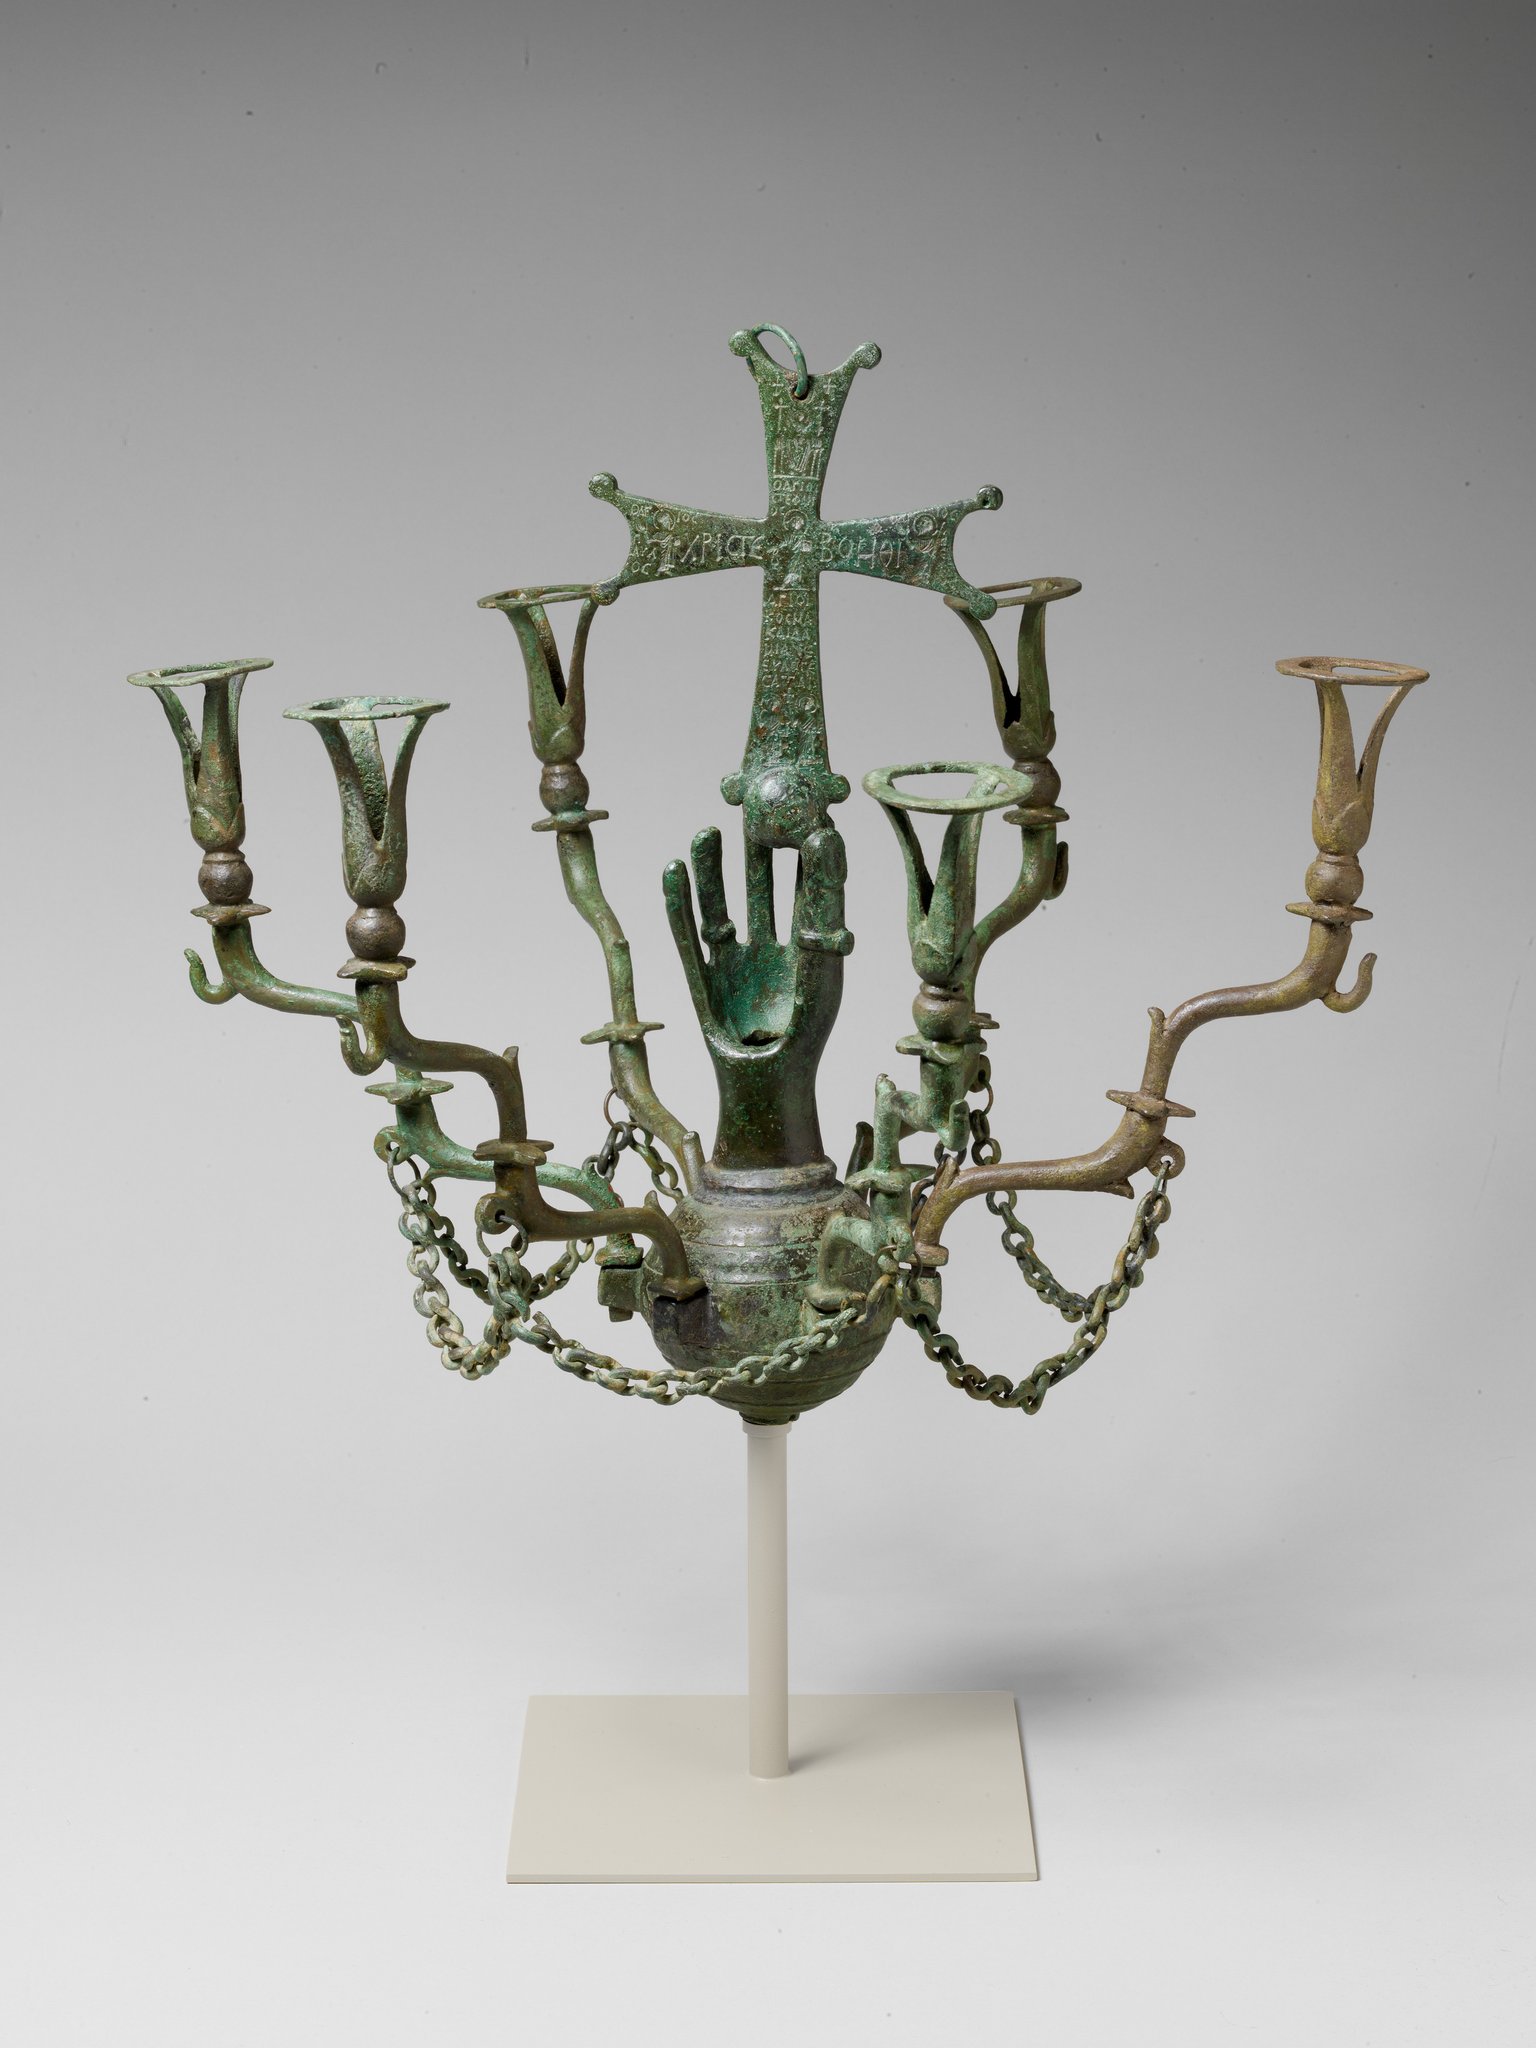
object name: chandelier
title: Hanging Lamp with a Hand Holding a Cross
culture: byzantine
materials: copper alloy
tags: hands,cross